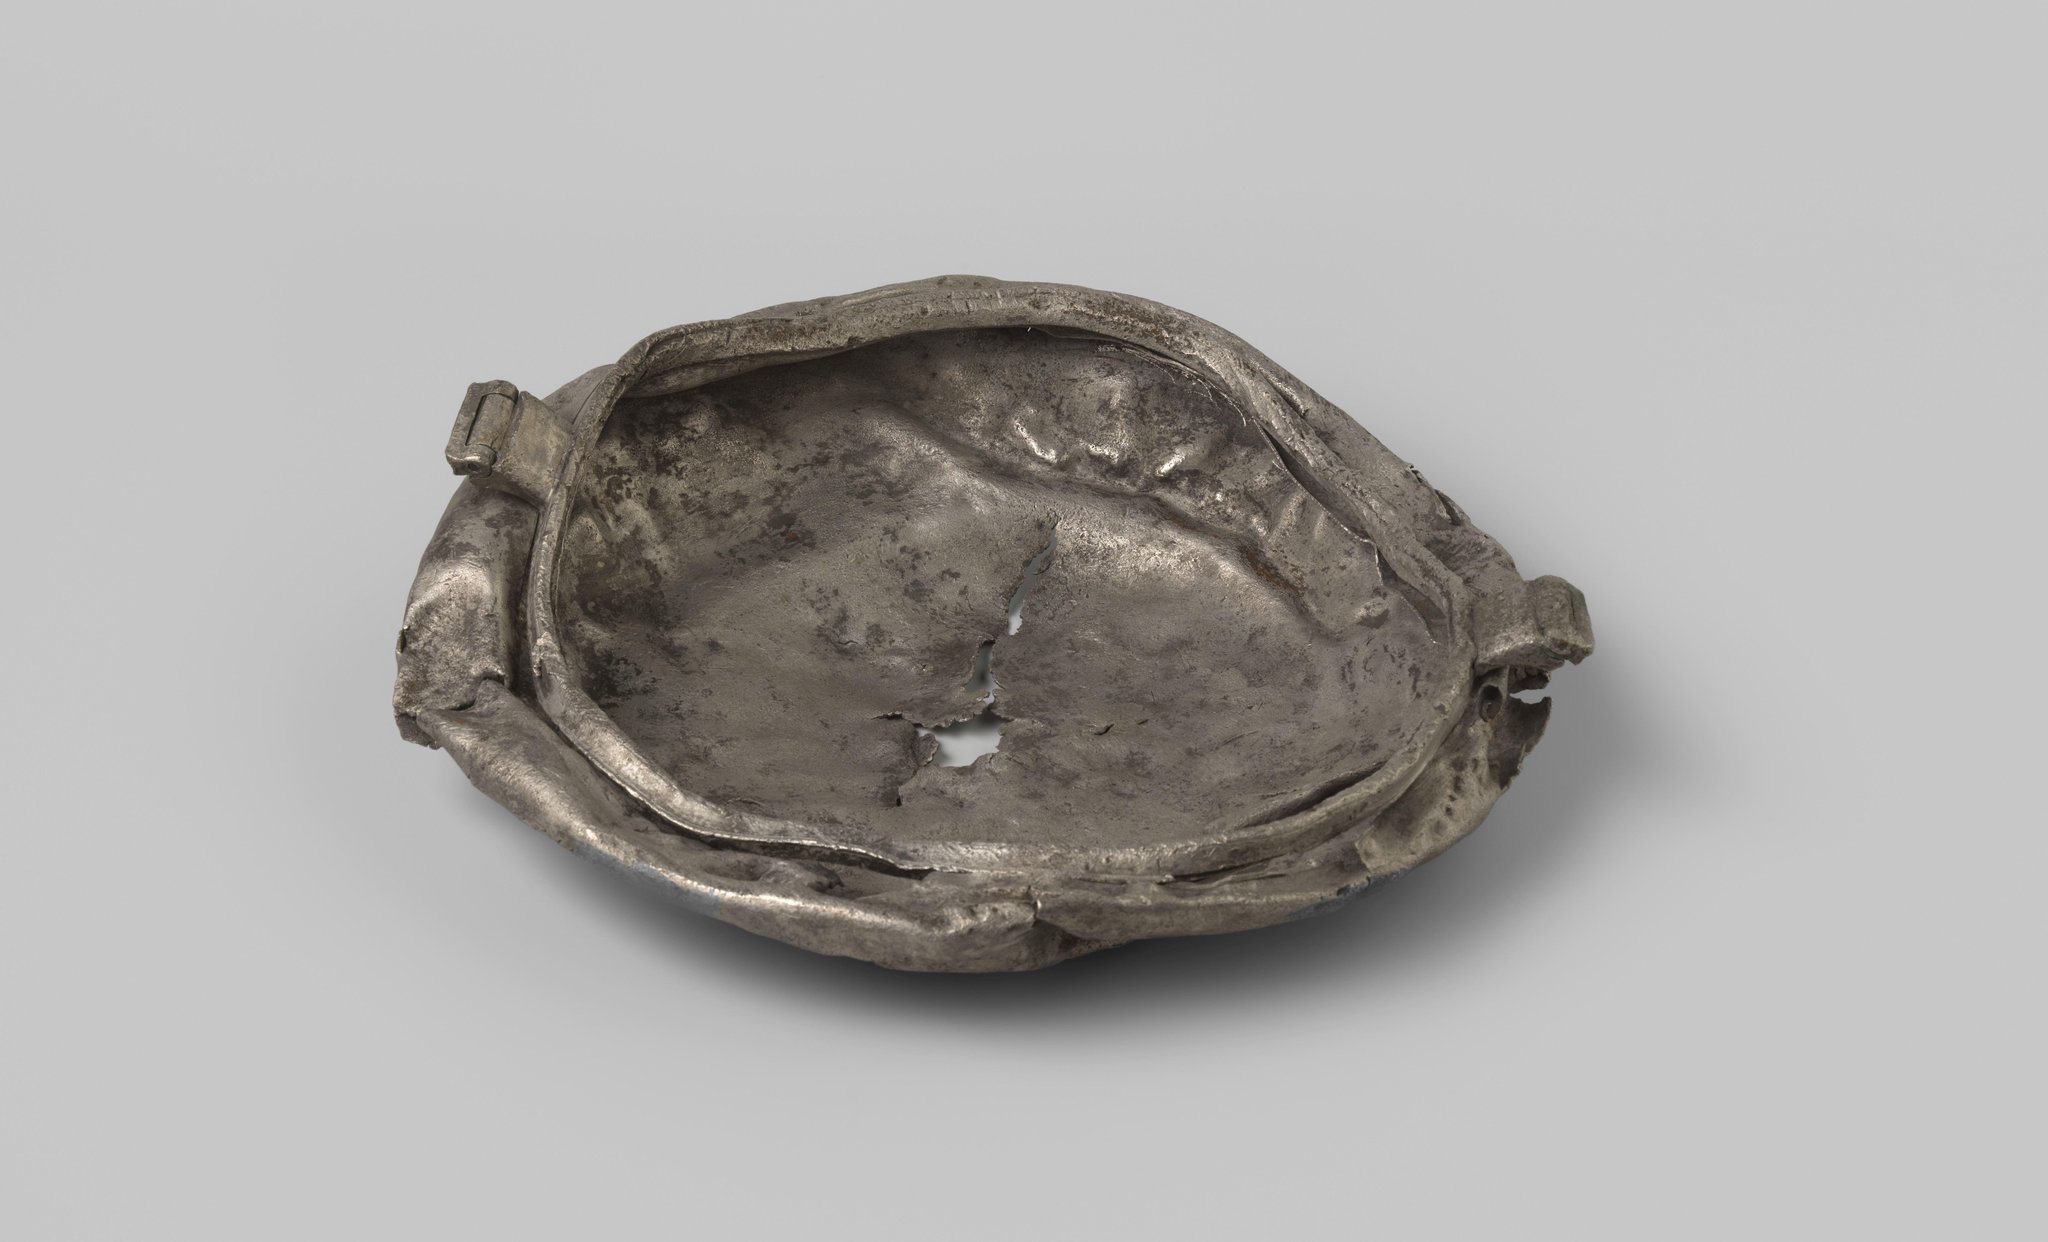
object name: dish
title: Schaal uit het wrak van de Oost-Indiëvaarder Hollandia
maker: Anonymous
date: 1700-1743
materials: tin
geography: netherlands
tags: verenigde oostindische compagnie, hollandia (schip), annet